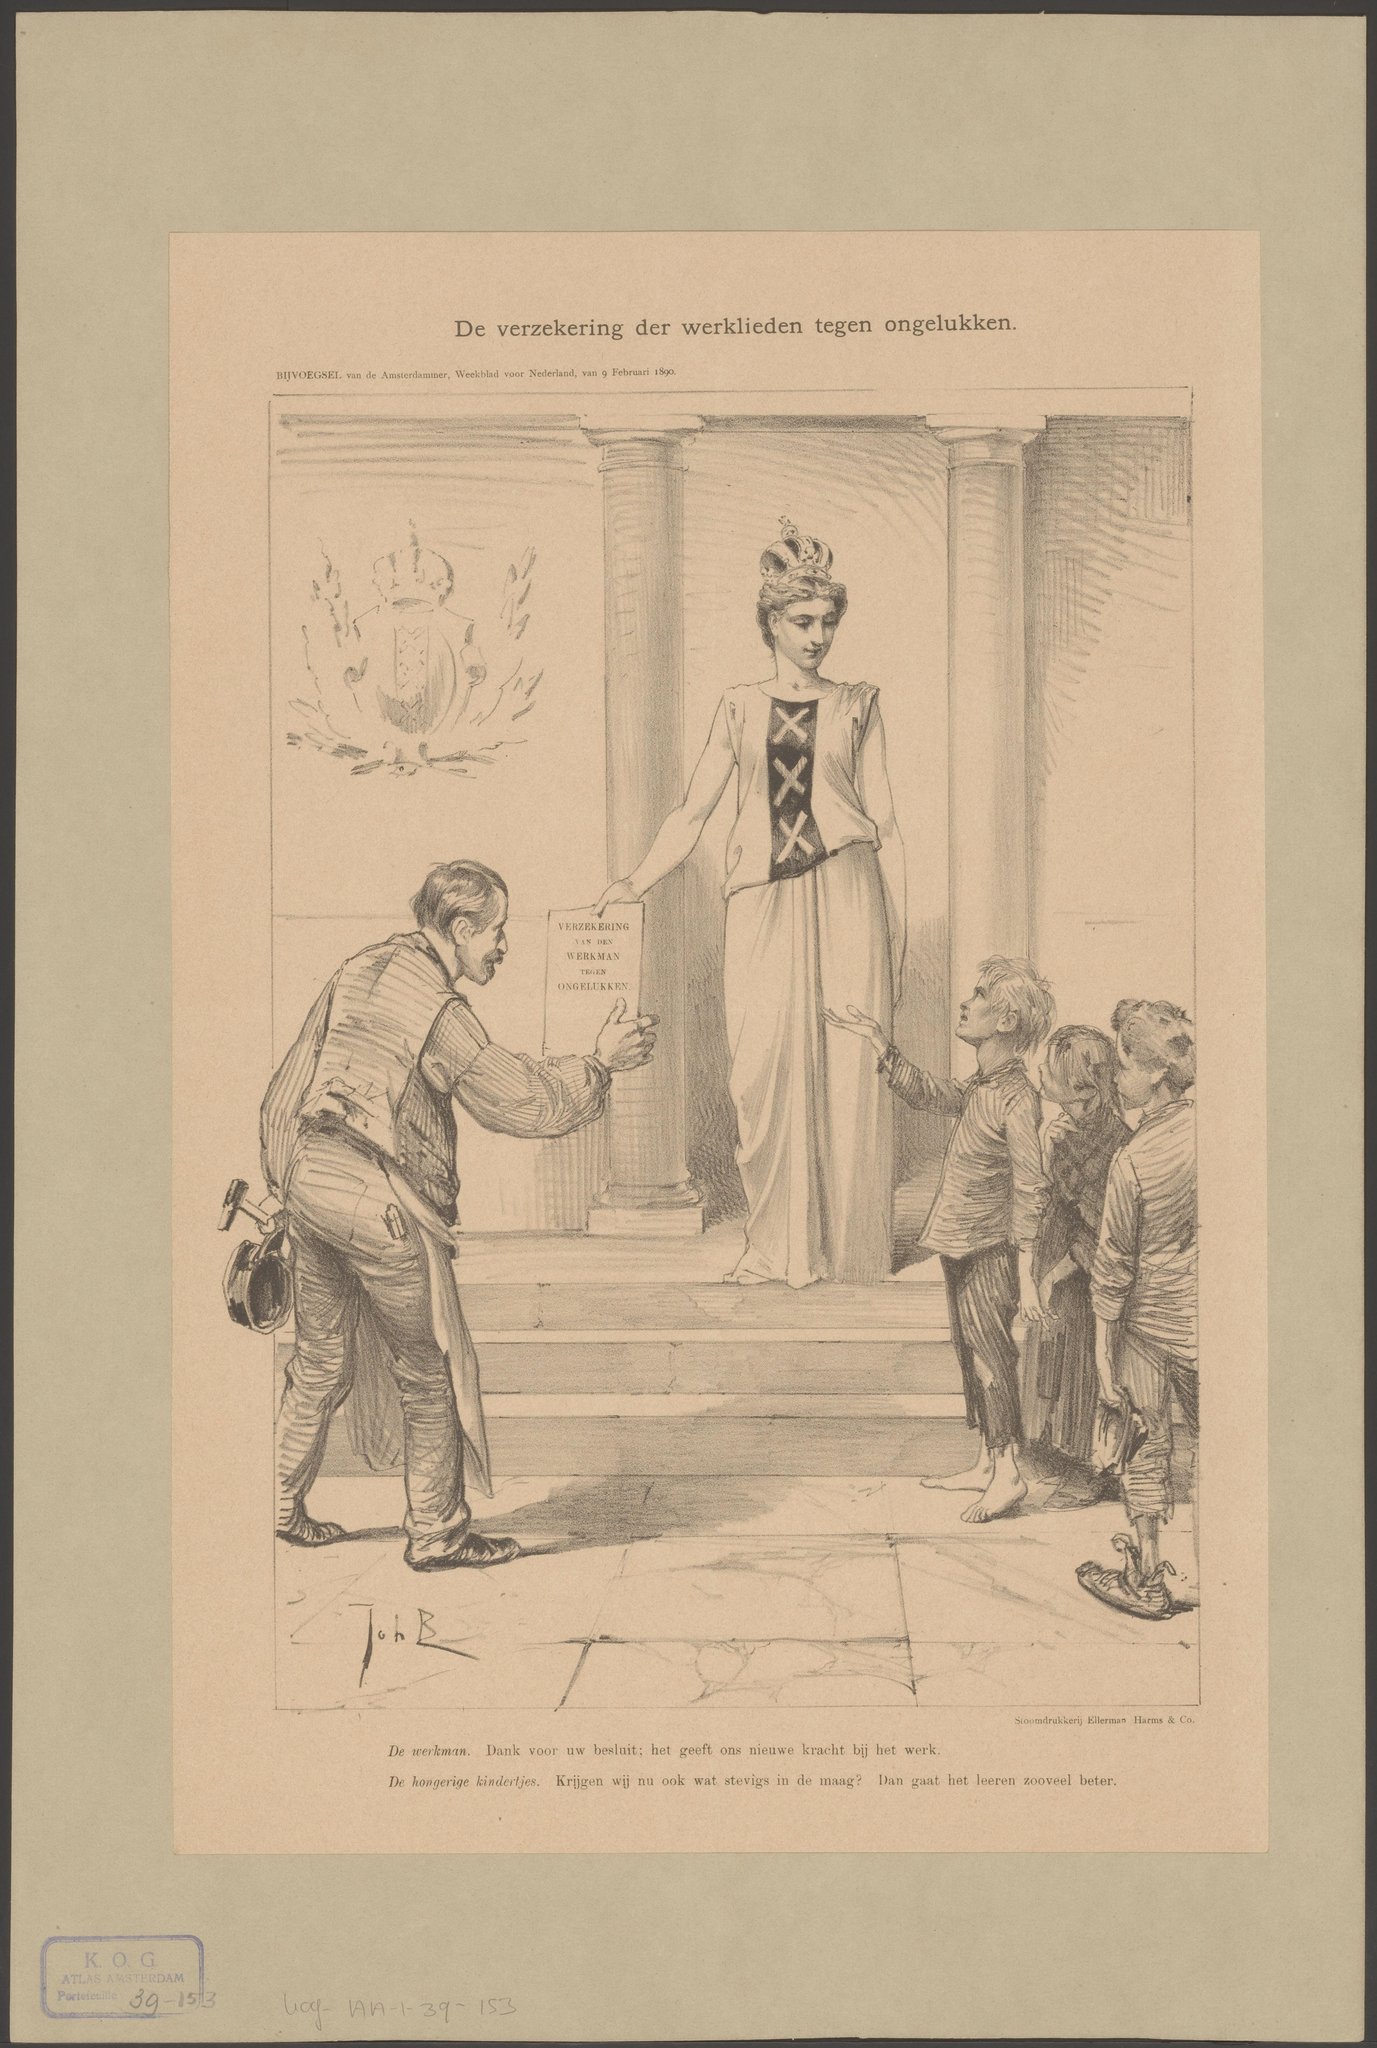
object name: print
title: De verzekering der werklieden tegen ongelukken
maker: johan braakensiek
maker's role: draughtsman, print maker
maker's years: 1858-1940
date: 1890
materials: paper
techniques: letterpress printing, lithograph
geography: netherlands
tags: hunger, personification of a city, town-patron(ess), child, working class, labourers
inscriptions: collector's mark: Lugt 1641b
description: Een werkman krijgt van de Amsterdamse stedenmaagd een bewijs van verzekering aangereikt. Een groep arme kinderen vraagt om iets te eten zodat ze beter kunnen leren. Onderwerpsrubriek binnen de Atlas Amsterdam: Armwezen en liefdadige instellingen: IV. Prenten betrekking hebbende op Philantropie.